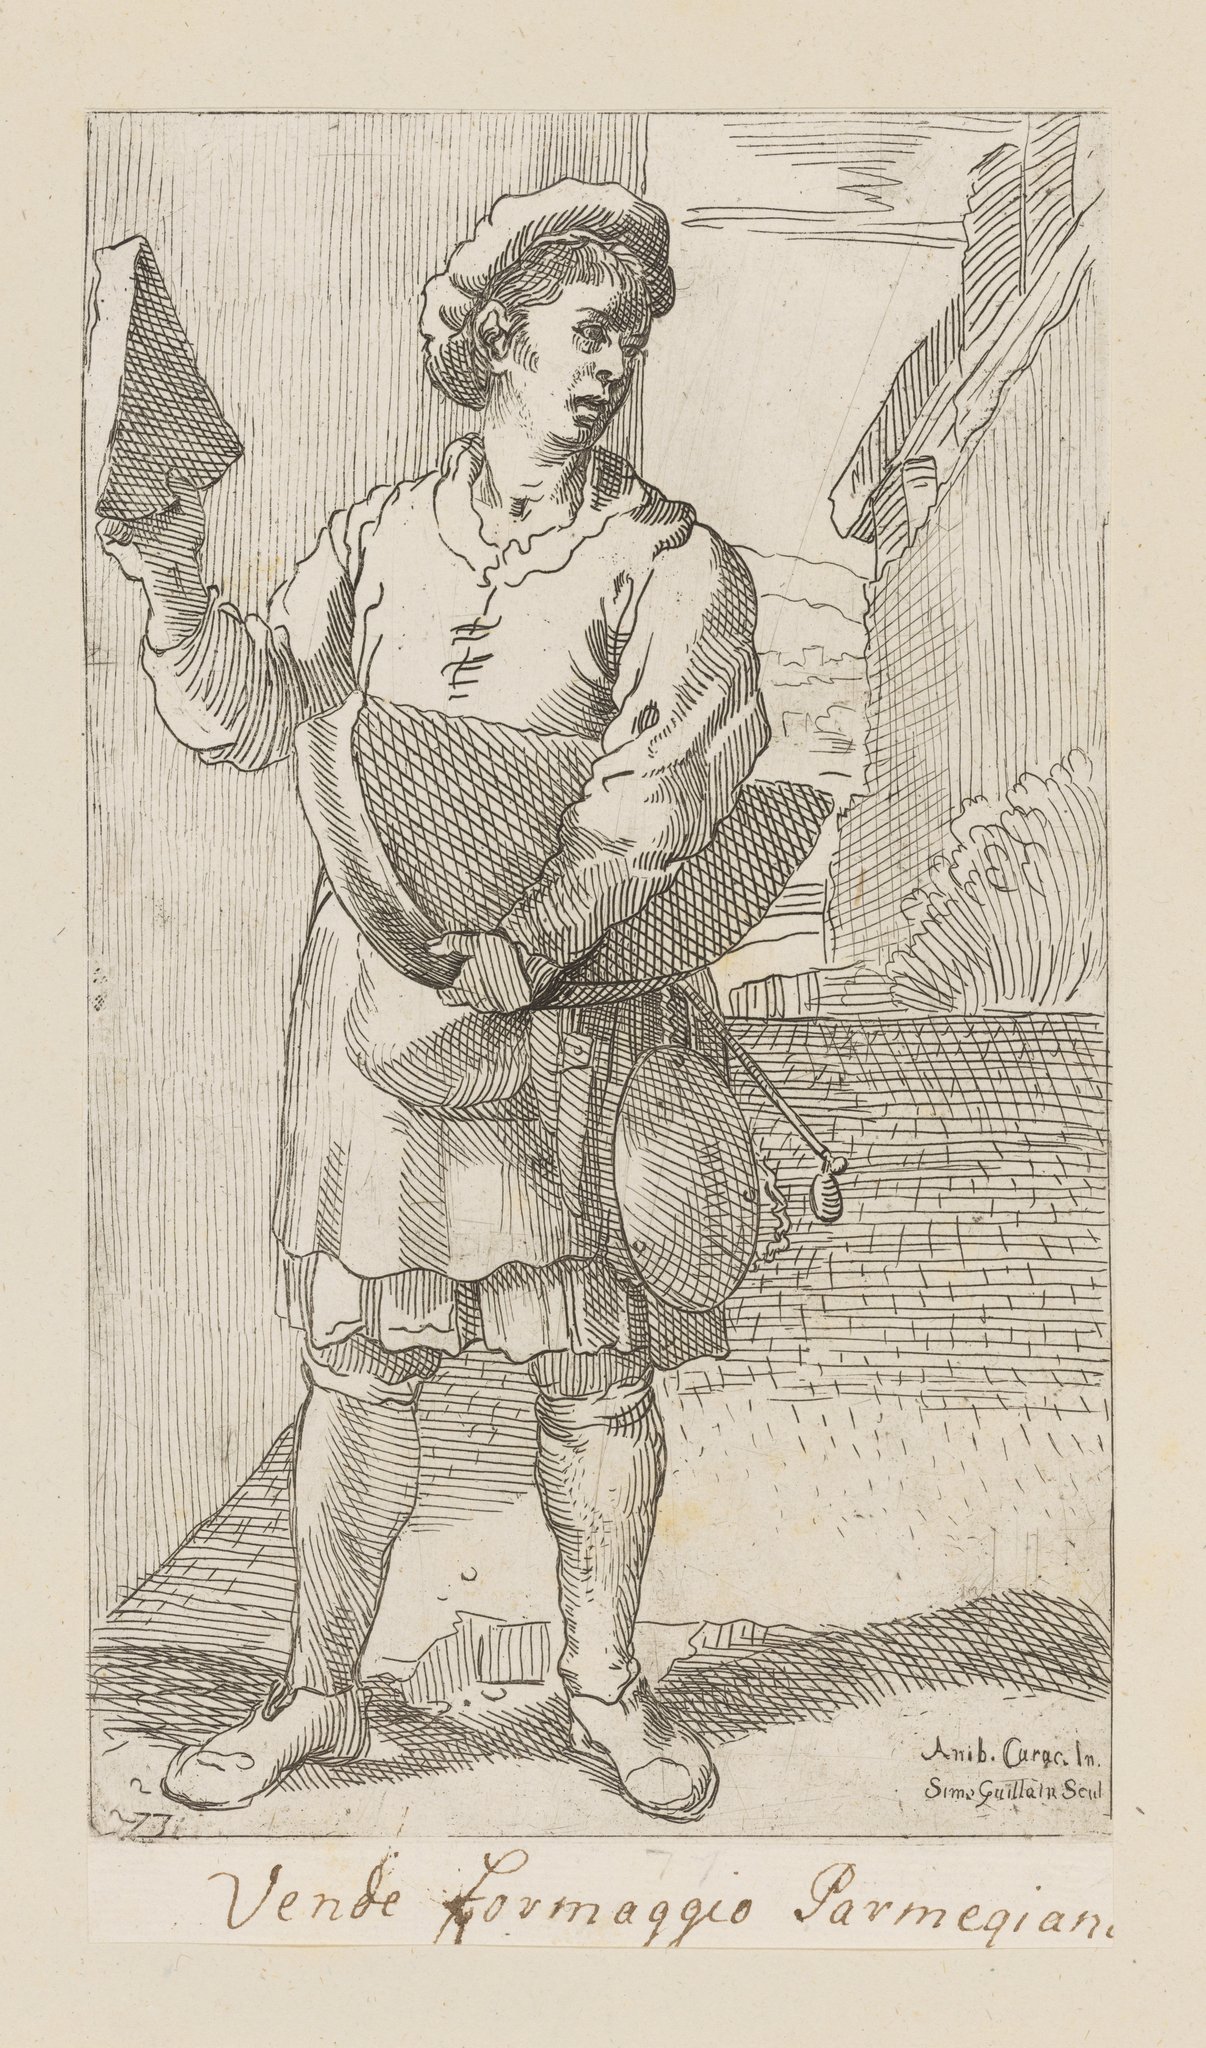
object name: print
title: Plate 76: Seller of Parmesan Cheese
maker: simon guillain ii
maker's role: artist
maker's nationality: french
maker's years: 1618-1718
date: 1646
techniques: etching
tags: cheese